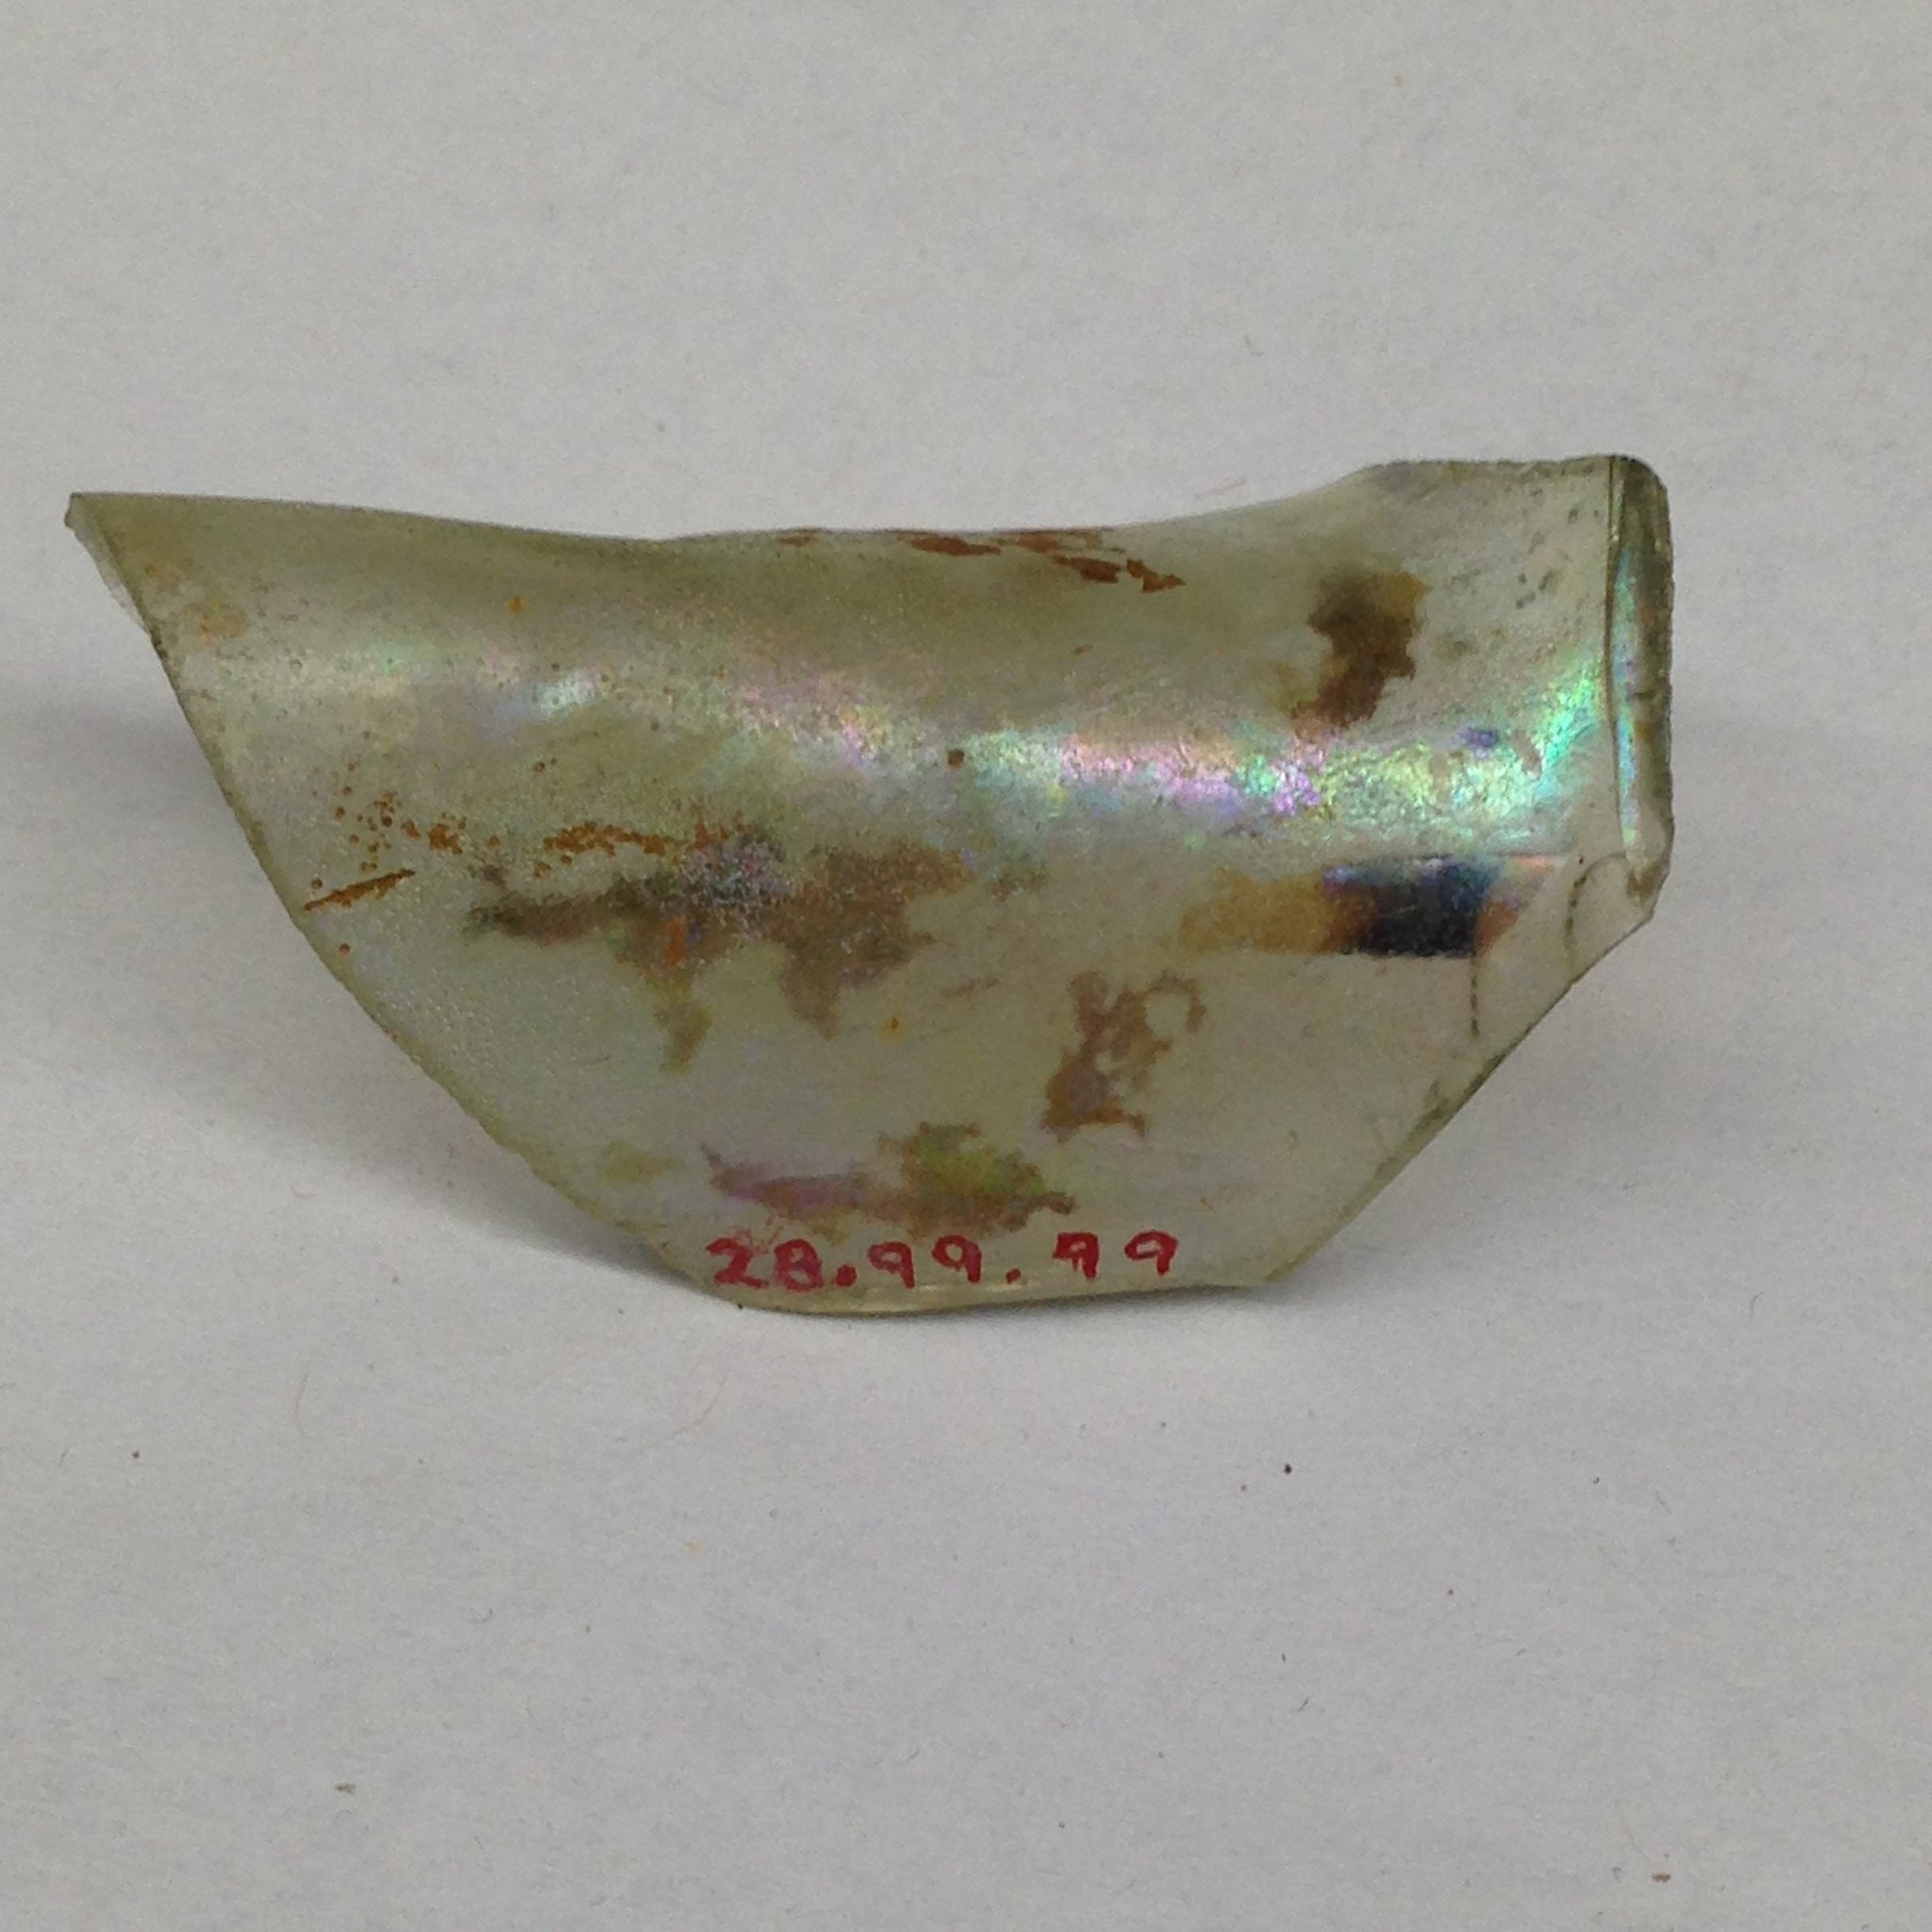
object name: fragment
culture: european or middle eastern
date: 1150-1250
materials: ceramic, glass